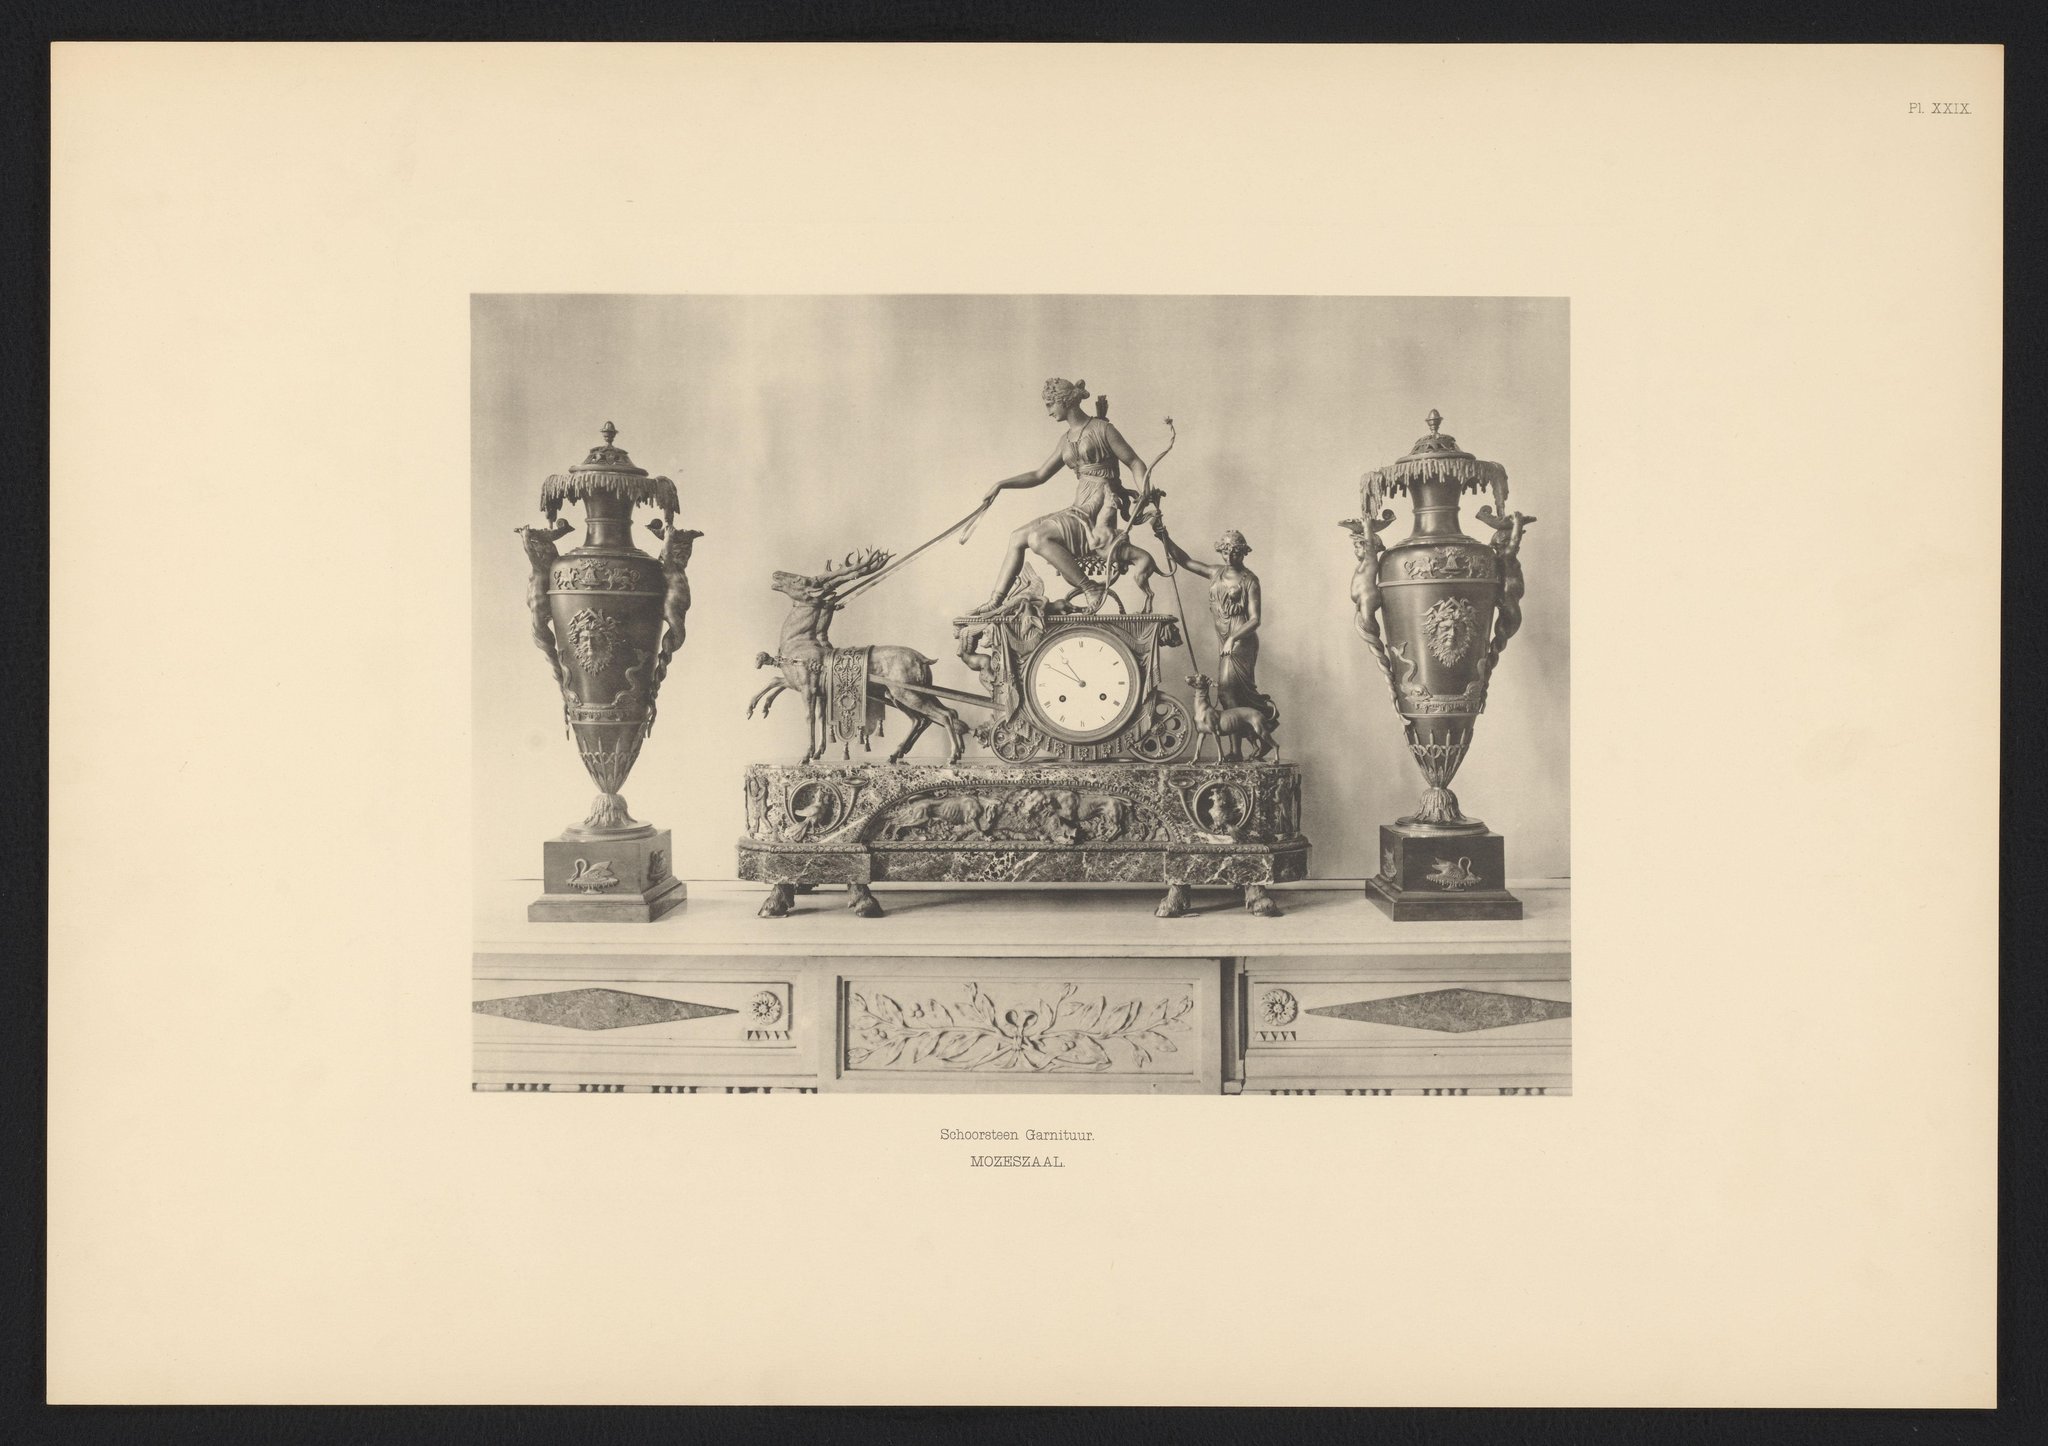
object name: photograph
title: Klok en twee decoratieve vazen op schoorsteenmantel in de Mozeszaal, Paleis op de Dam, Amsterdam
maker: Anonymous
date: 1899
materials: cardboard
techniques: photograph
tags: containers, palace, royal palace of amsterdam